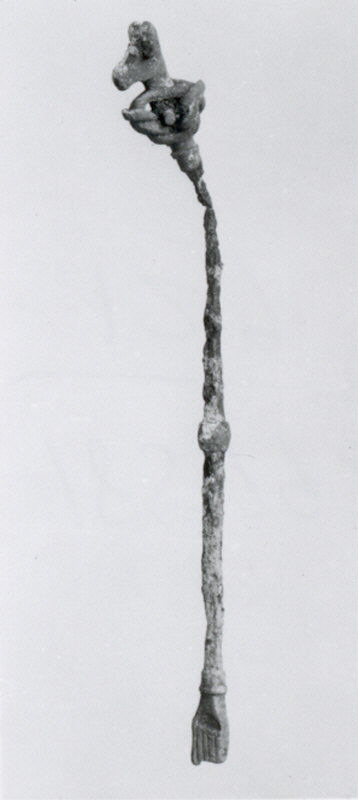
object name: staff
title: Staff with Herakles knots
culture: sasanian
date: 201-600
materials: bronze, iron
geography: iran